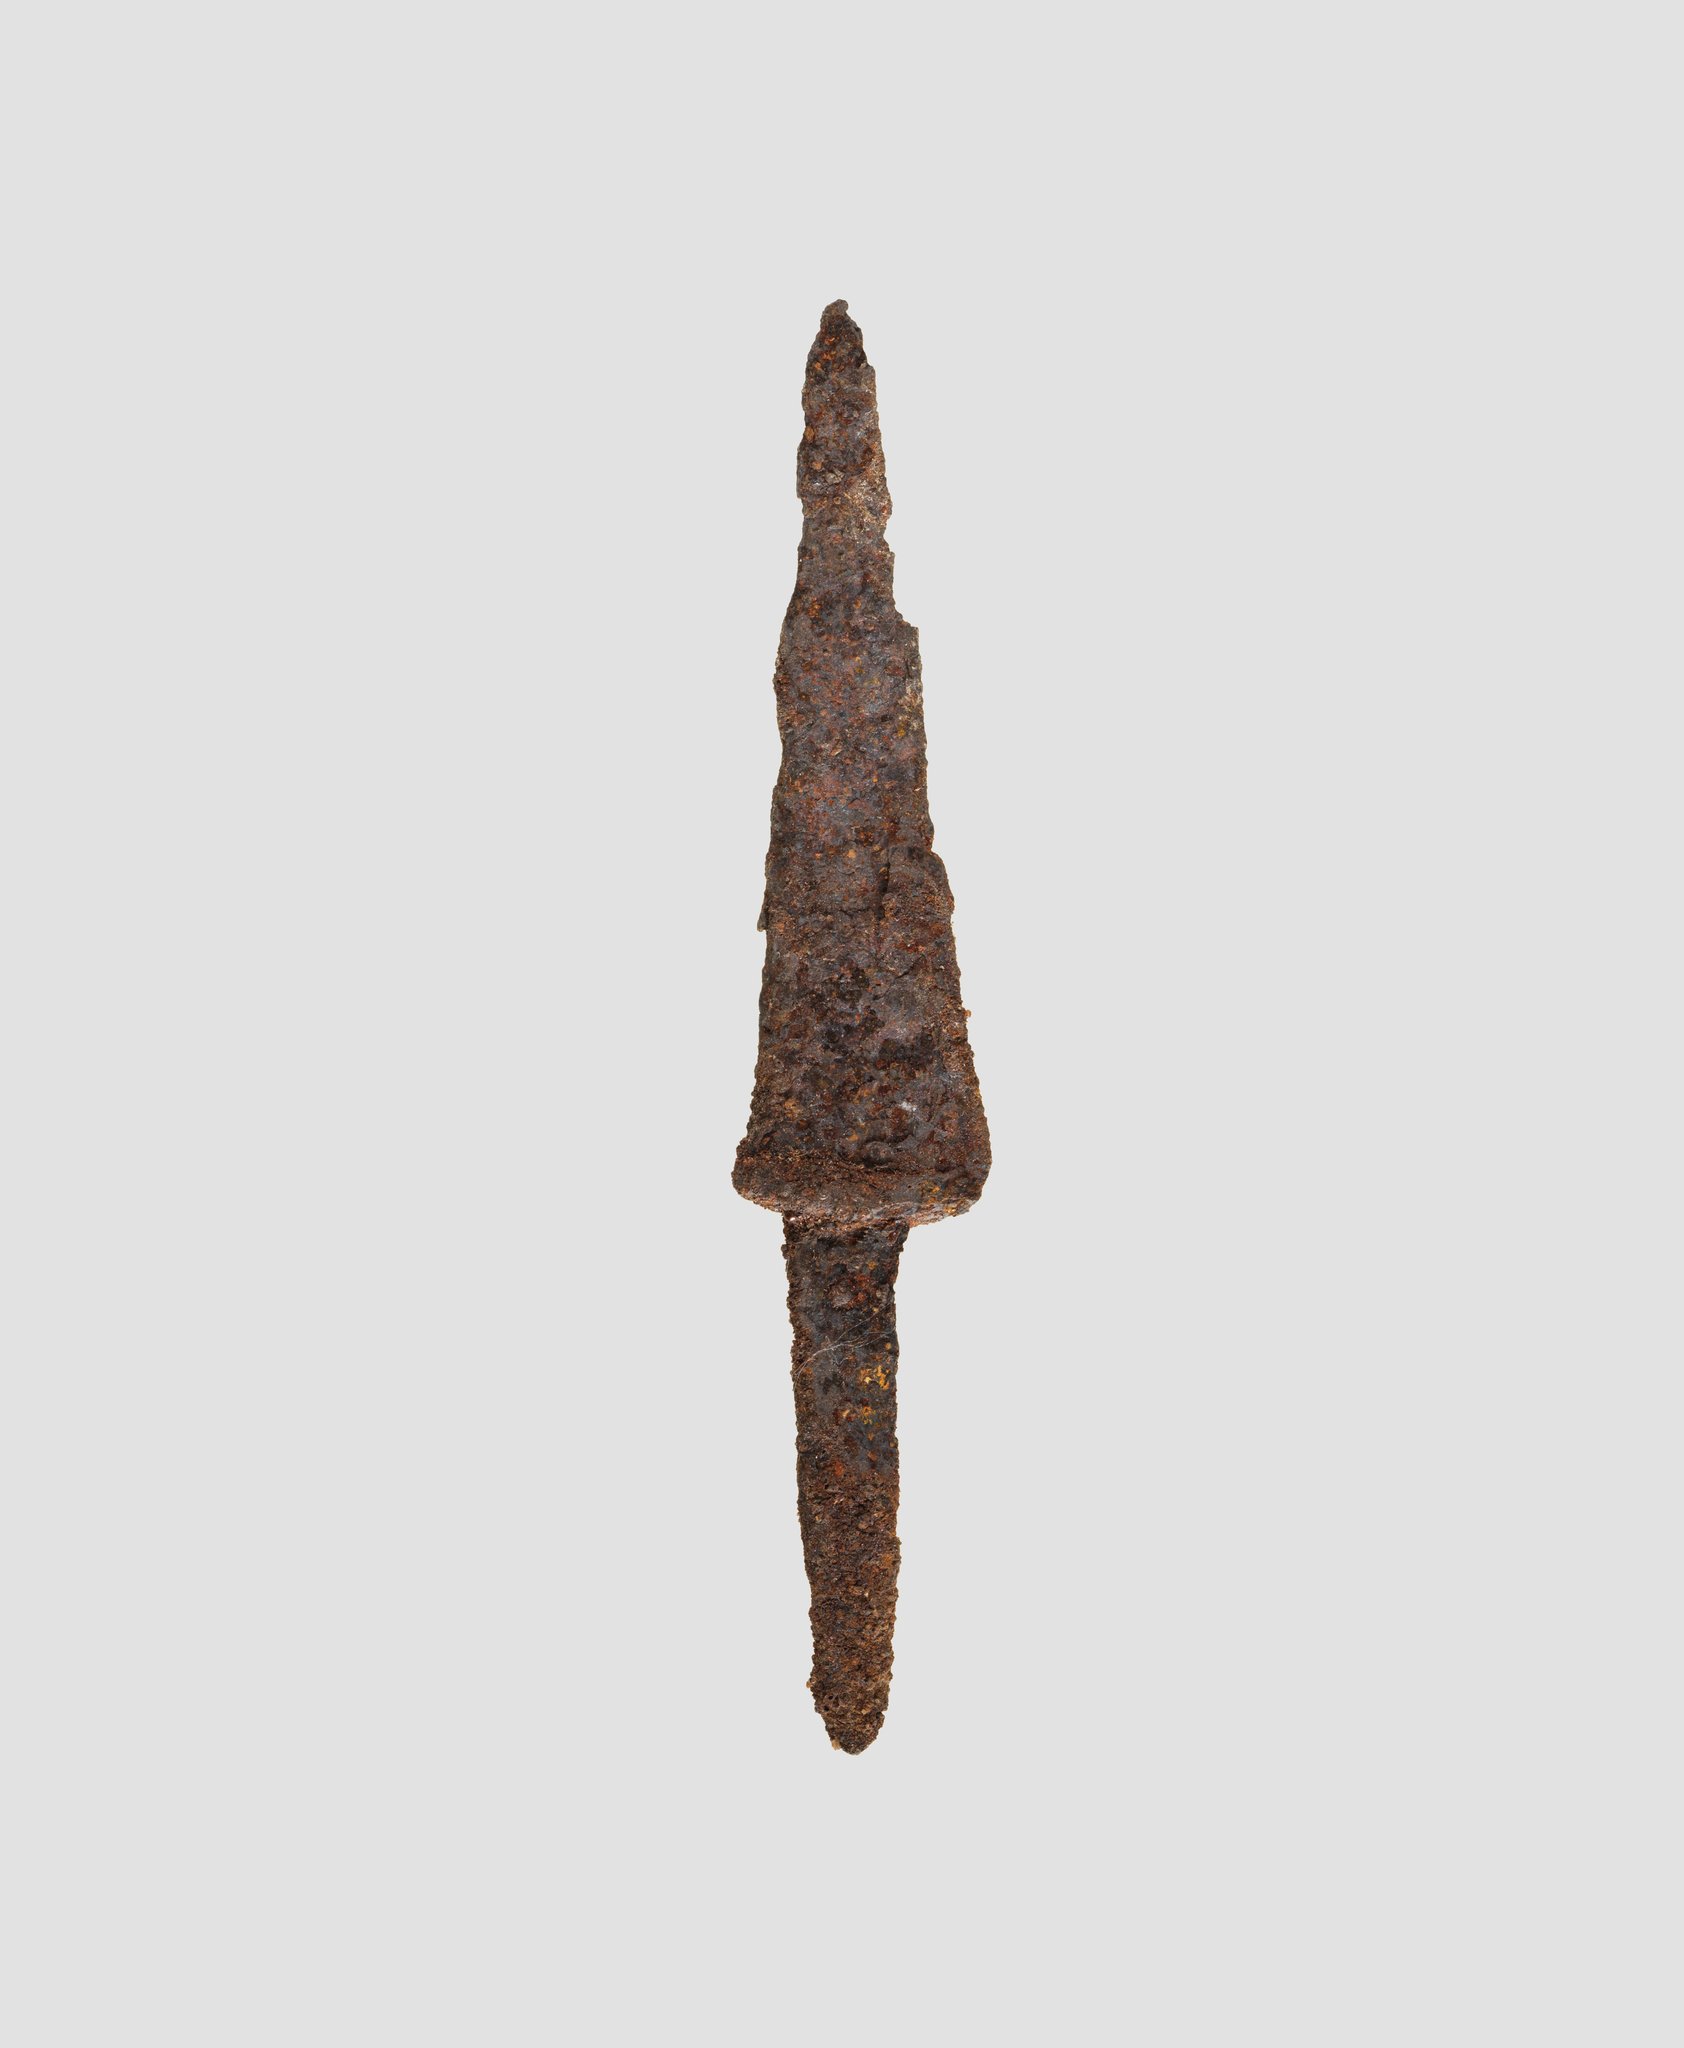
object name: arrow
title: Iron arrow tip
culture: alanic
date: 601-900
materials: metal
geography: caucasus